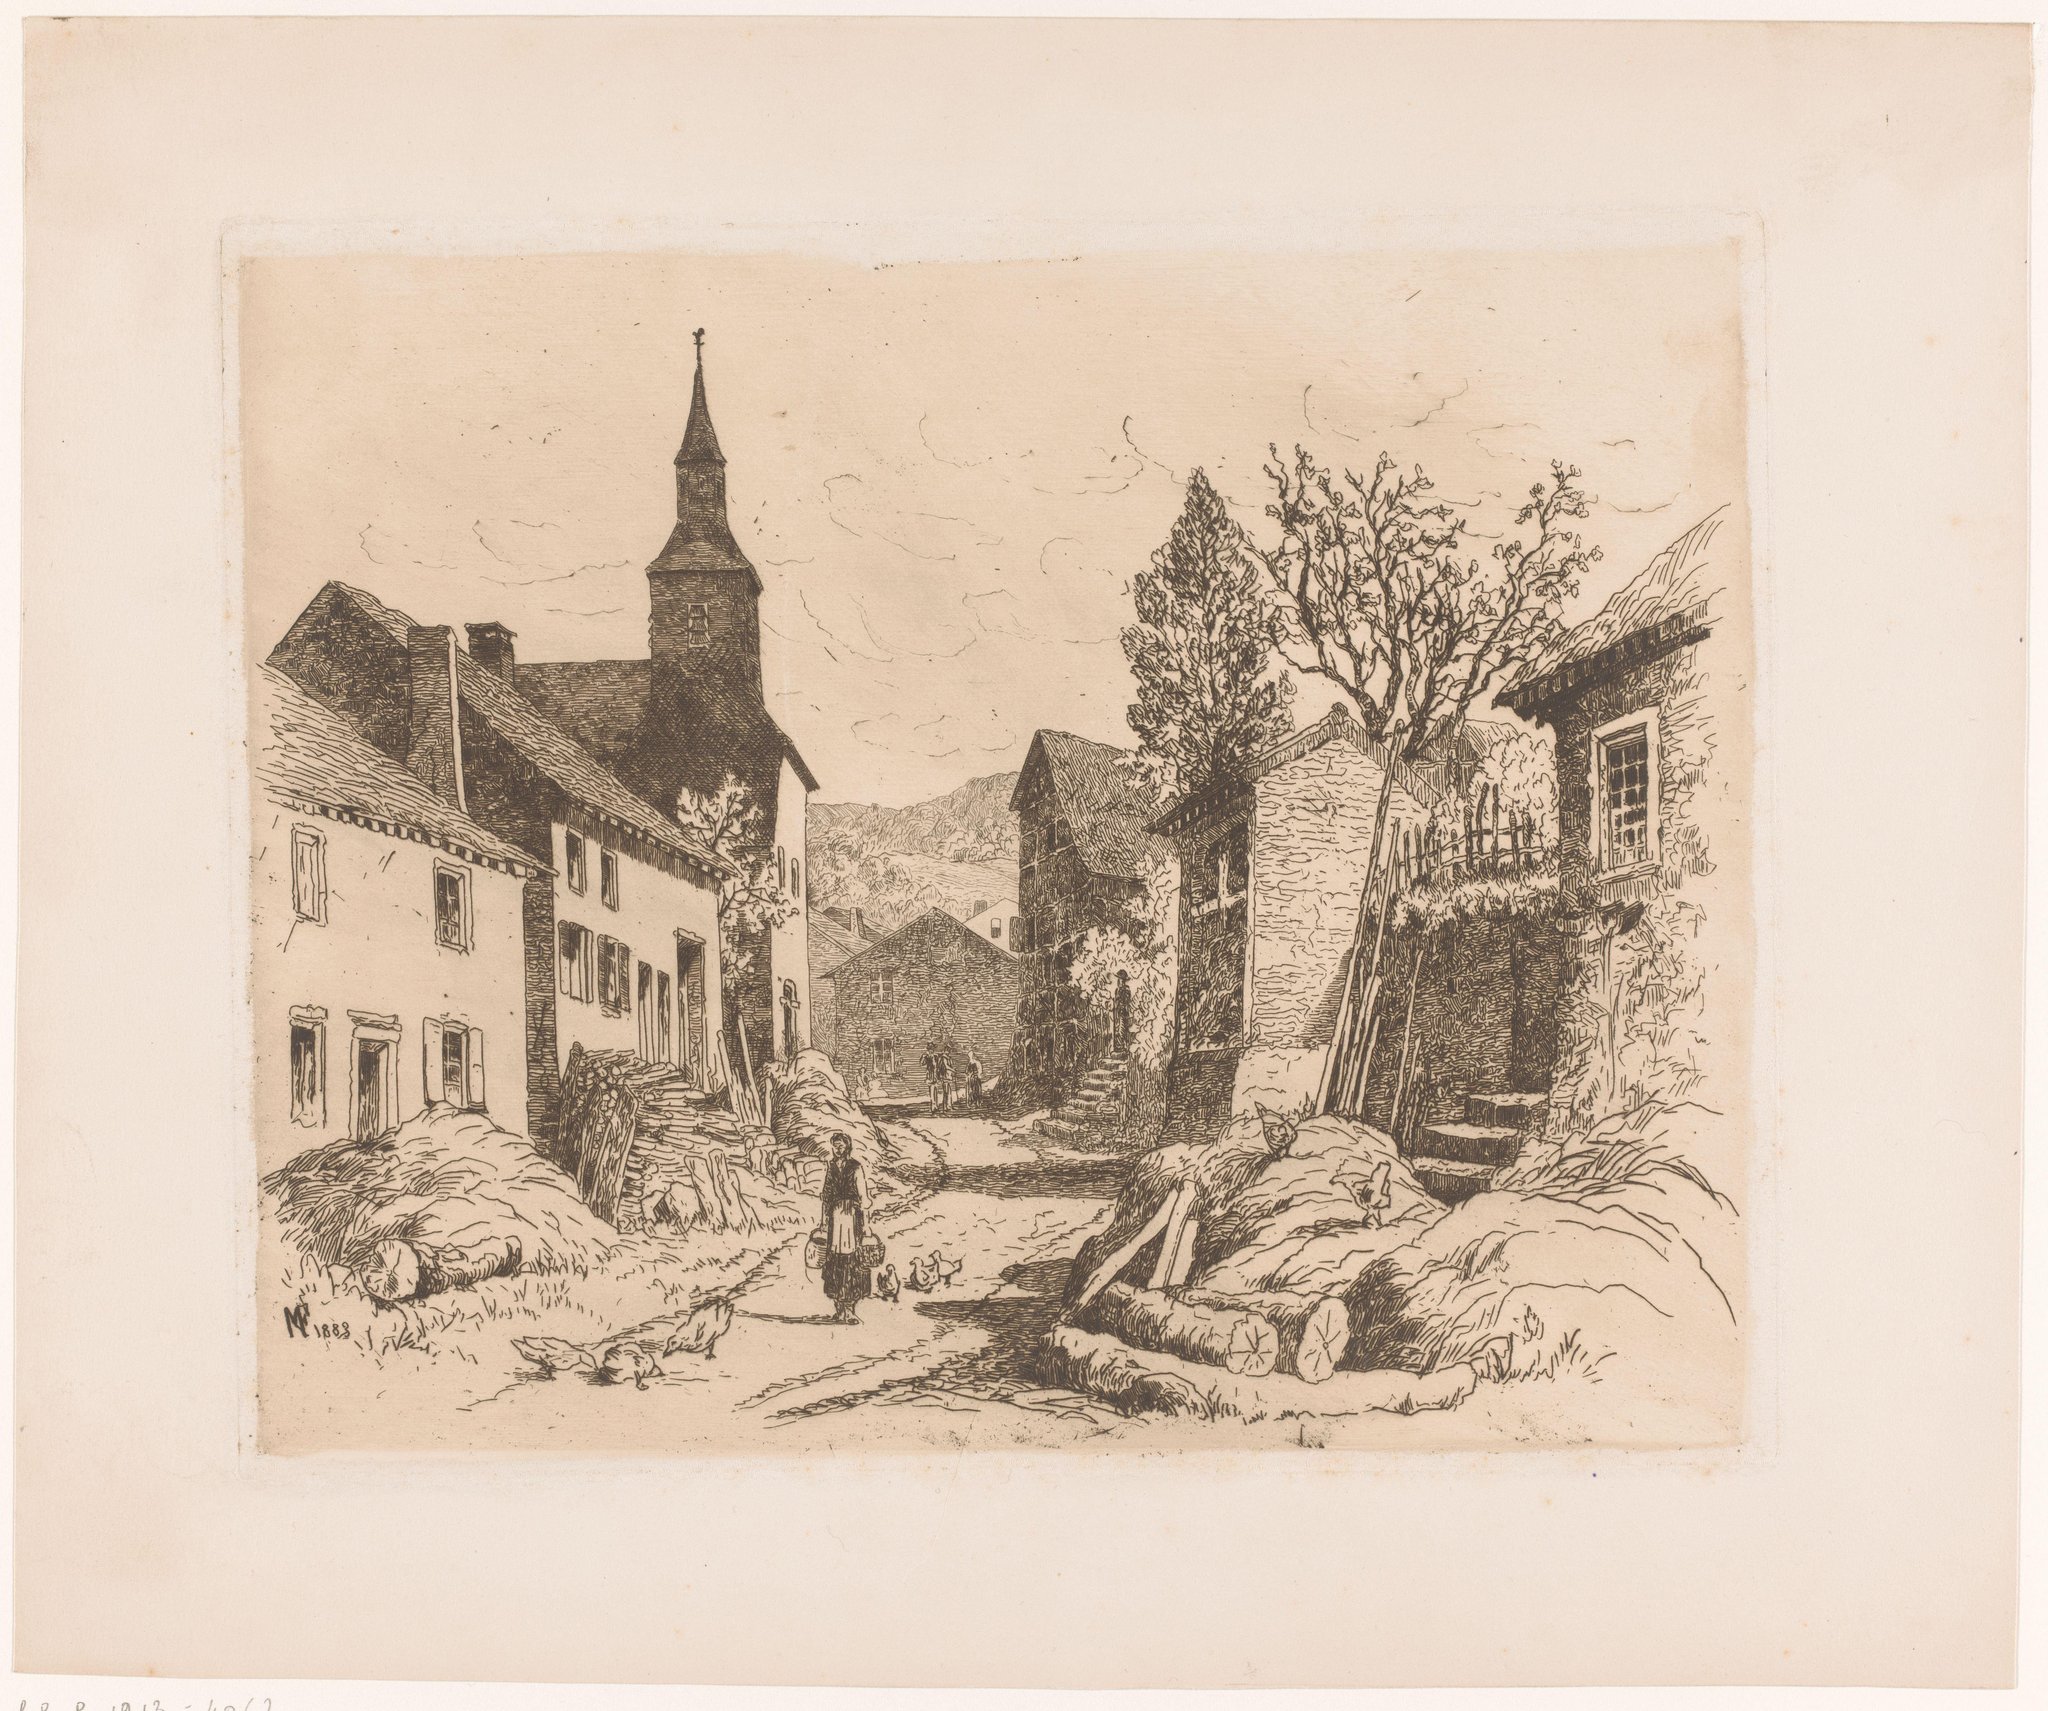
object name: print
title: Gezicht op een straat in een bergdorp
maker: maria van hohenzollern-sigmaringen (gravin van vlaanderen)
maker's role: print maker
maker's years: 1845-1912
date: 1883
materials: paper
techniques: drypoint, etching, intaglio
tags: village street, mountains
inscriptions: collector's mark: Lugt 2228